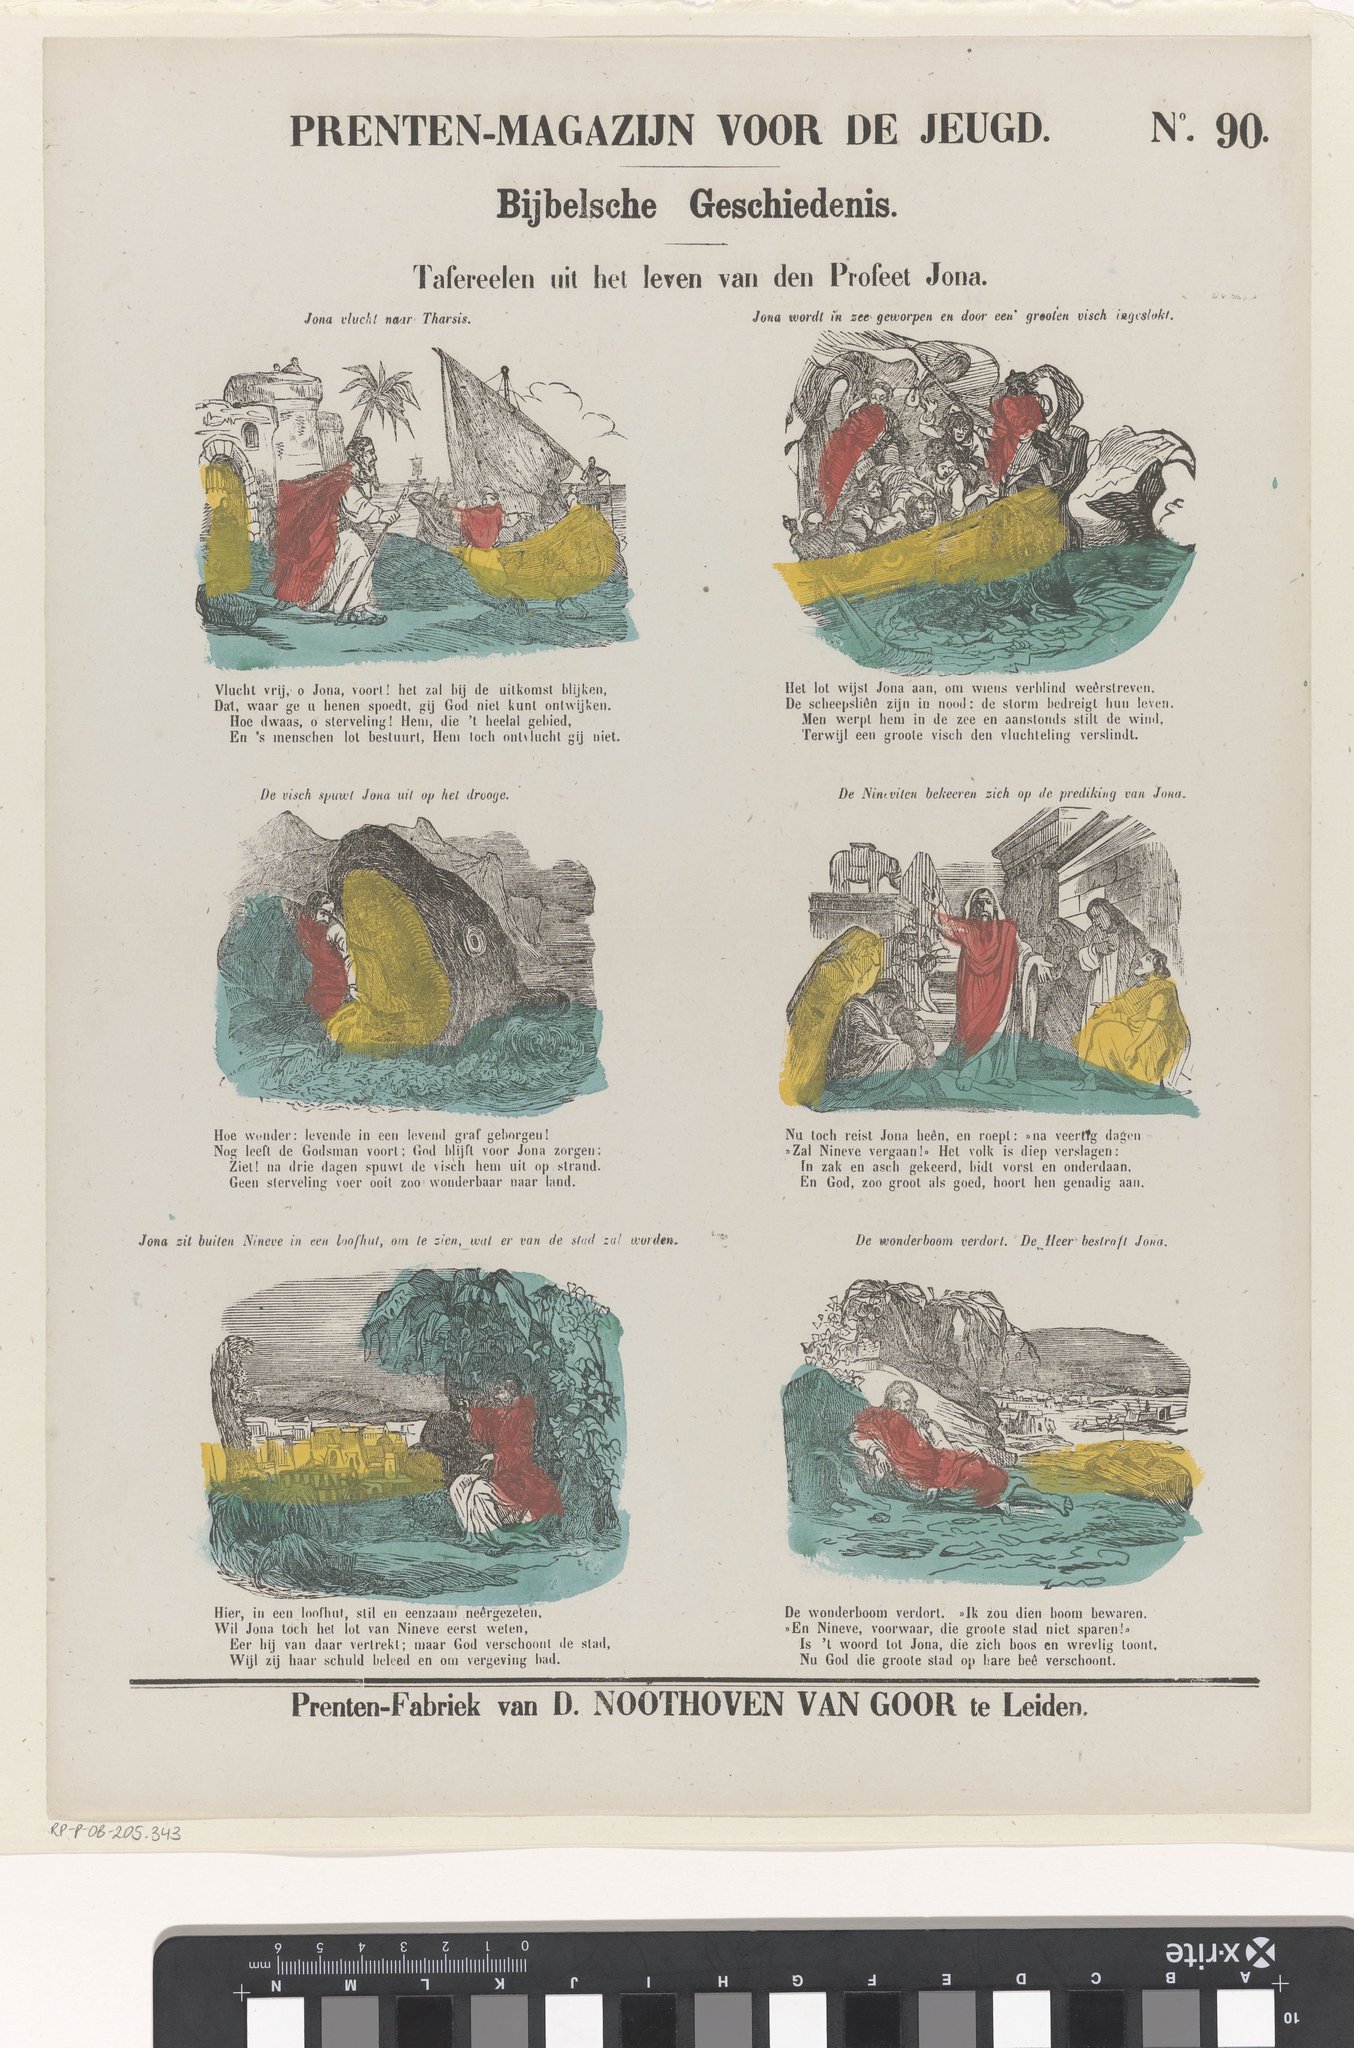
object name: popular print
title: Prenten-magazijn voor de jeugd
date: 1850-1881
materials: paper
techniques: colour, letterpress printing, engraving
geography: leiden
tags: the book of jonah, old testament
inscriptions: collector's mark: Lugt 2760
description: Blad met 6 voorstellingen uit het leven van de oudtestamentische profeet Jona. Boven elke voorstelling een titel en onder elke voorstelling een vierregelig vers. Genummerd rechtsboven: No. 90.